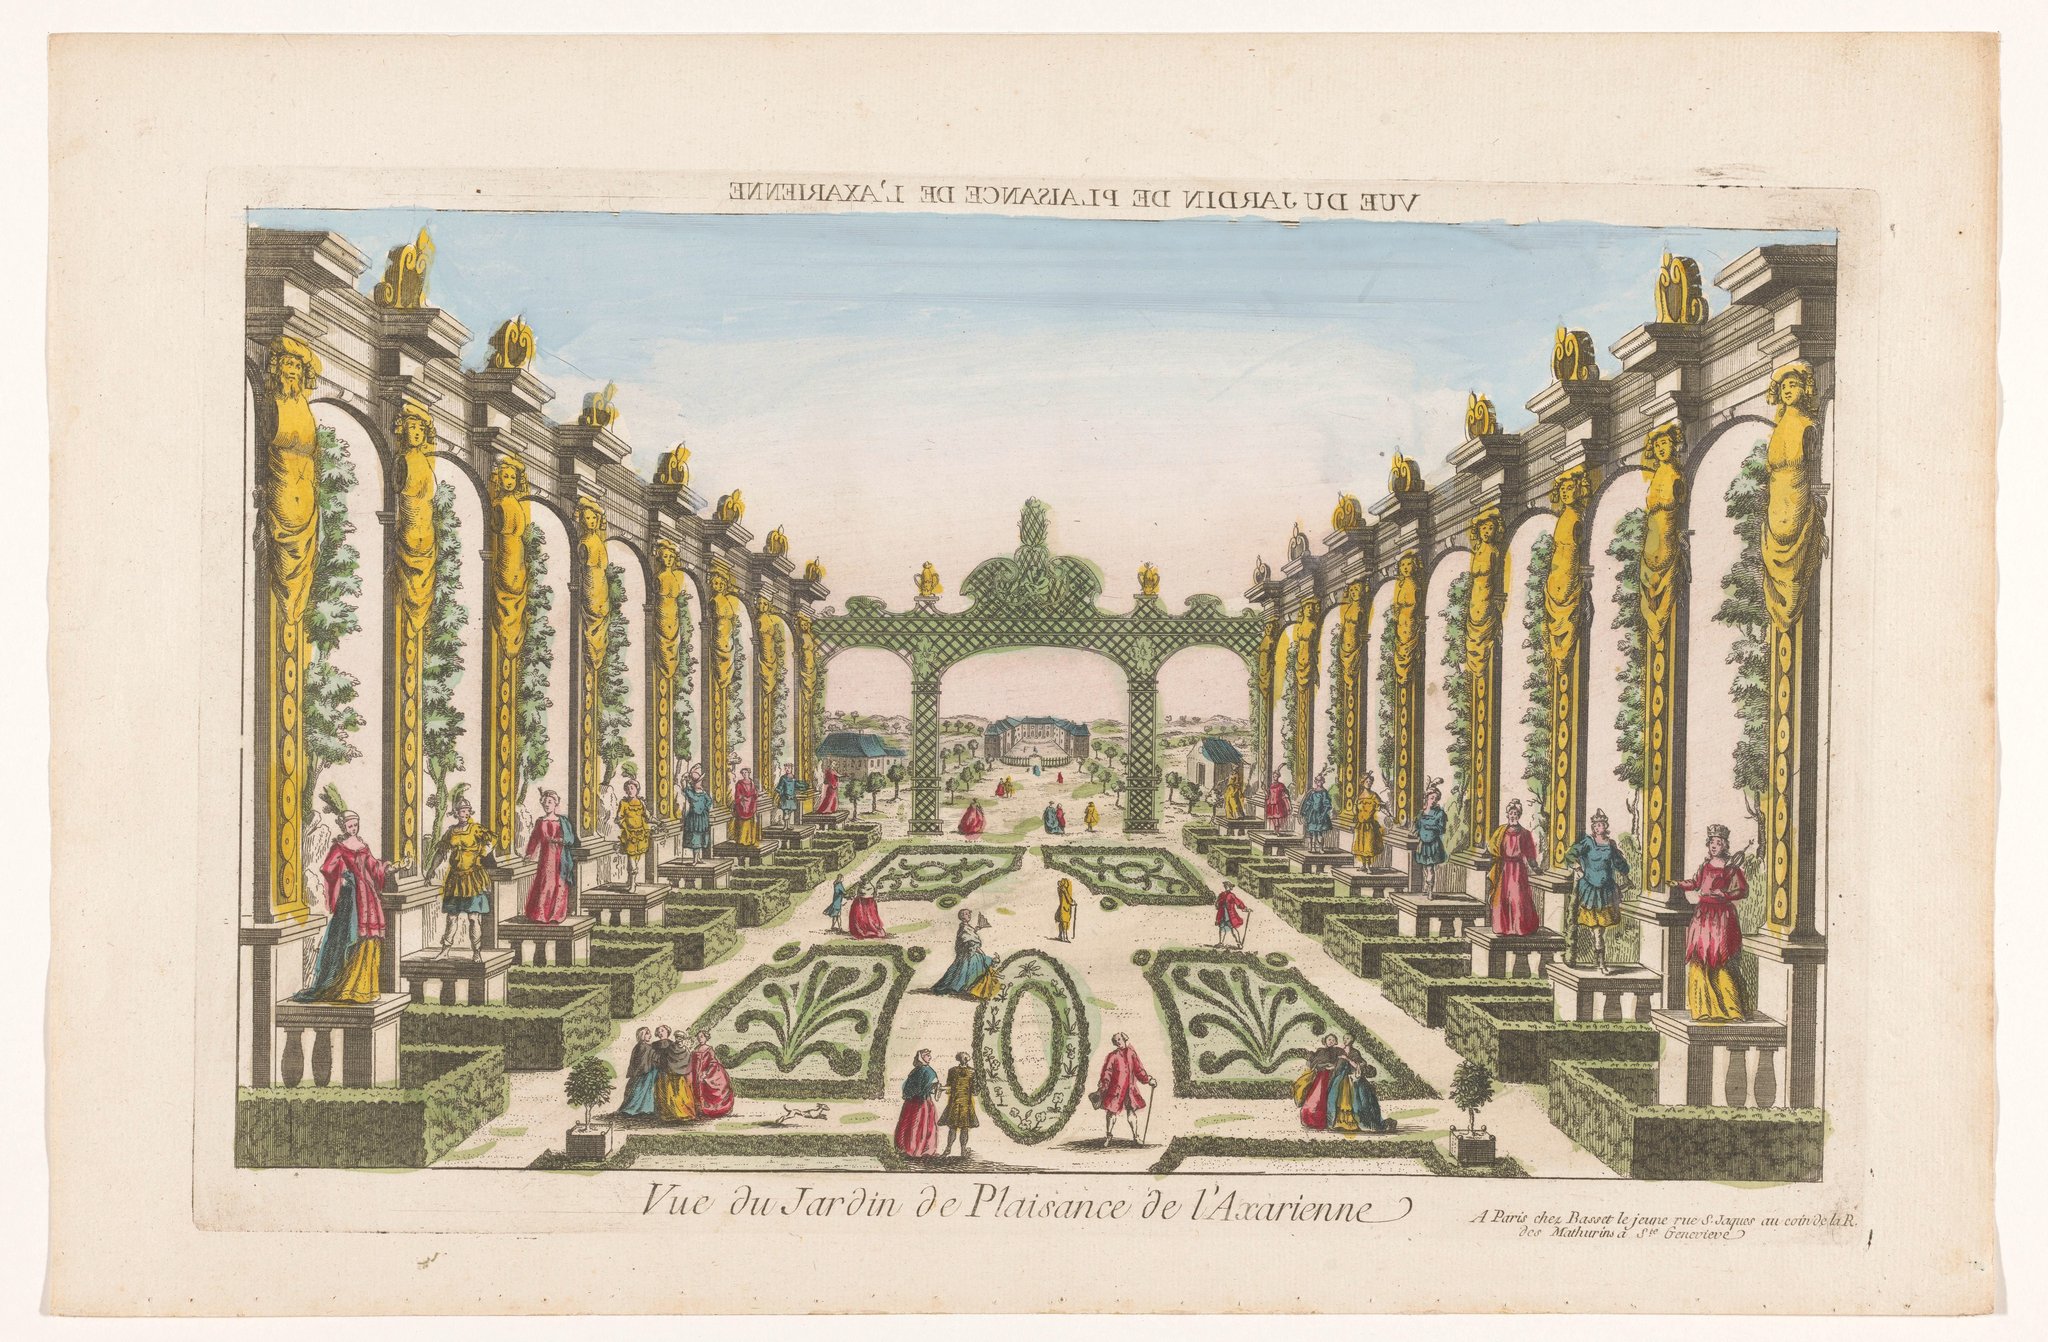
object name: print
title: Gezicht op de tuin van het kasteel Axarienne te Sint-Petersburg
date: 1700-1799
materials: paper, watercolor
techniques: brush, etching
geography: paris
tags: garden, ornamental plants, garden ornaments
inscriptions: collector's mark: Lugt 2166, watermark